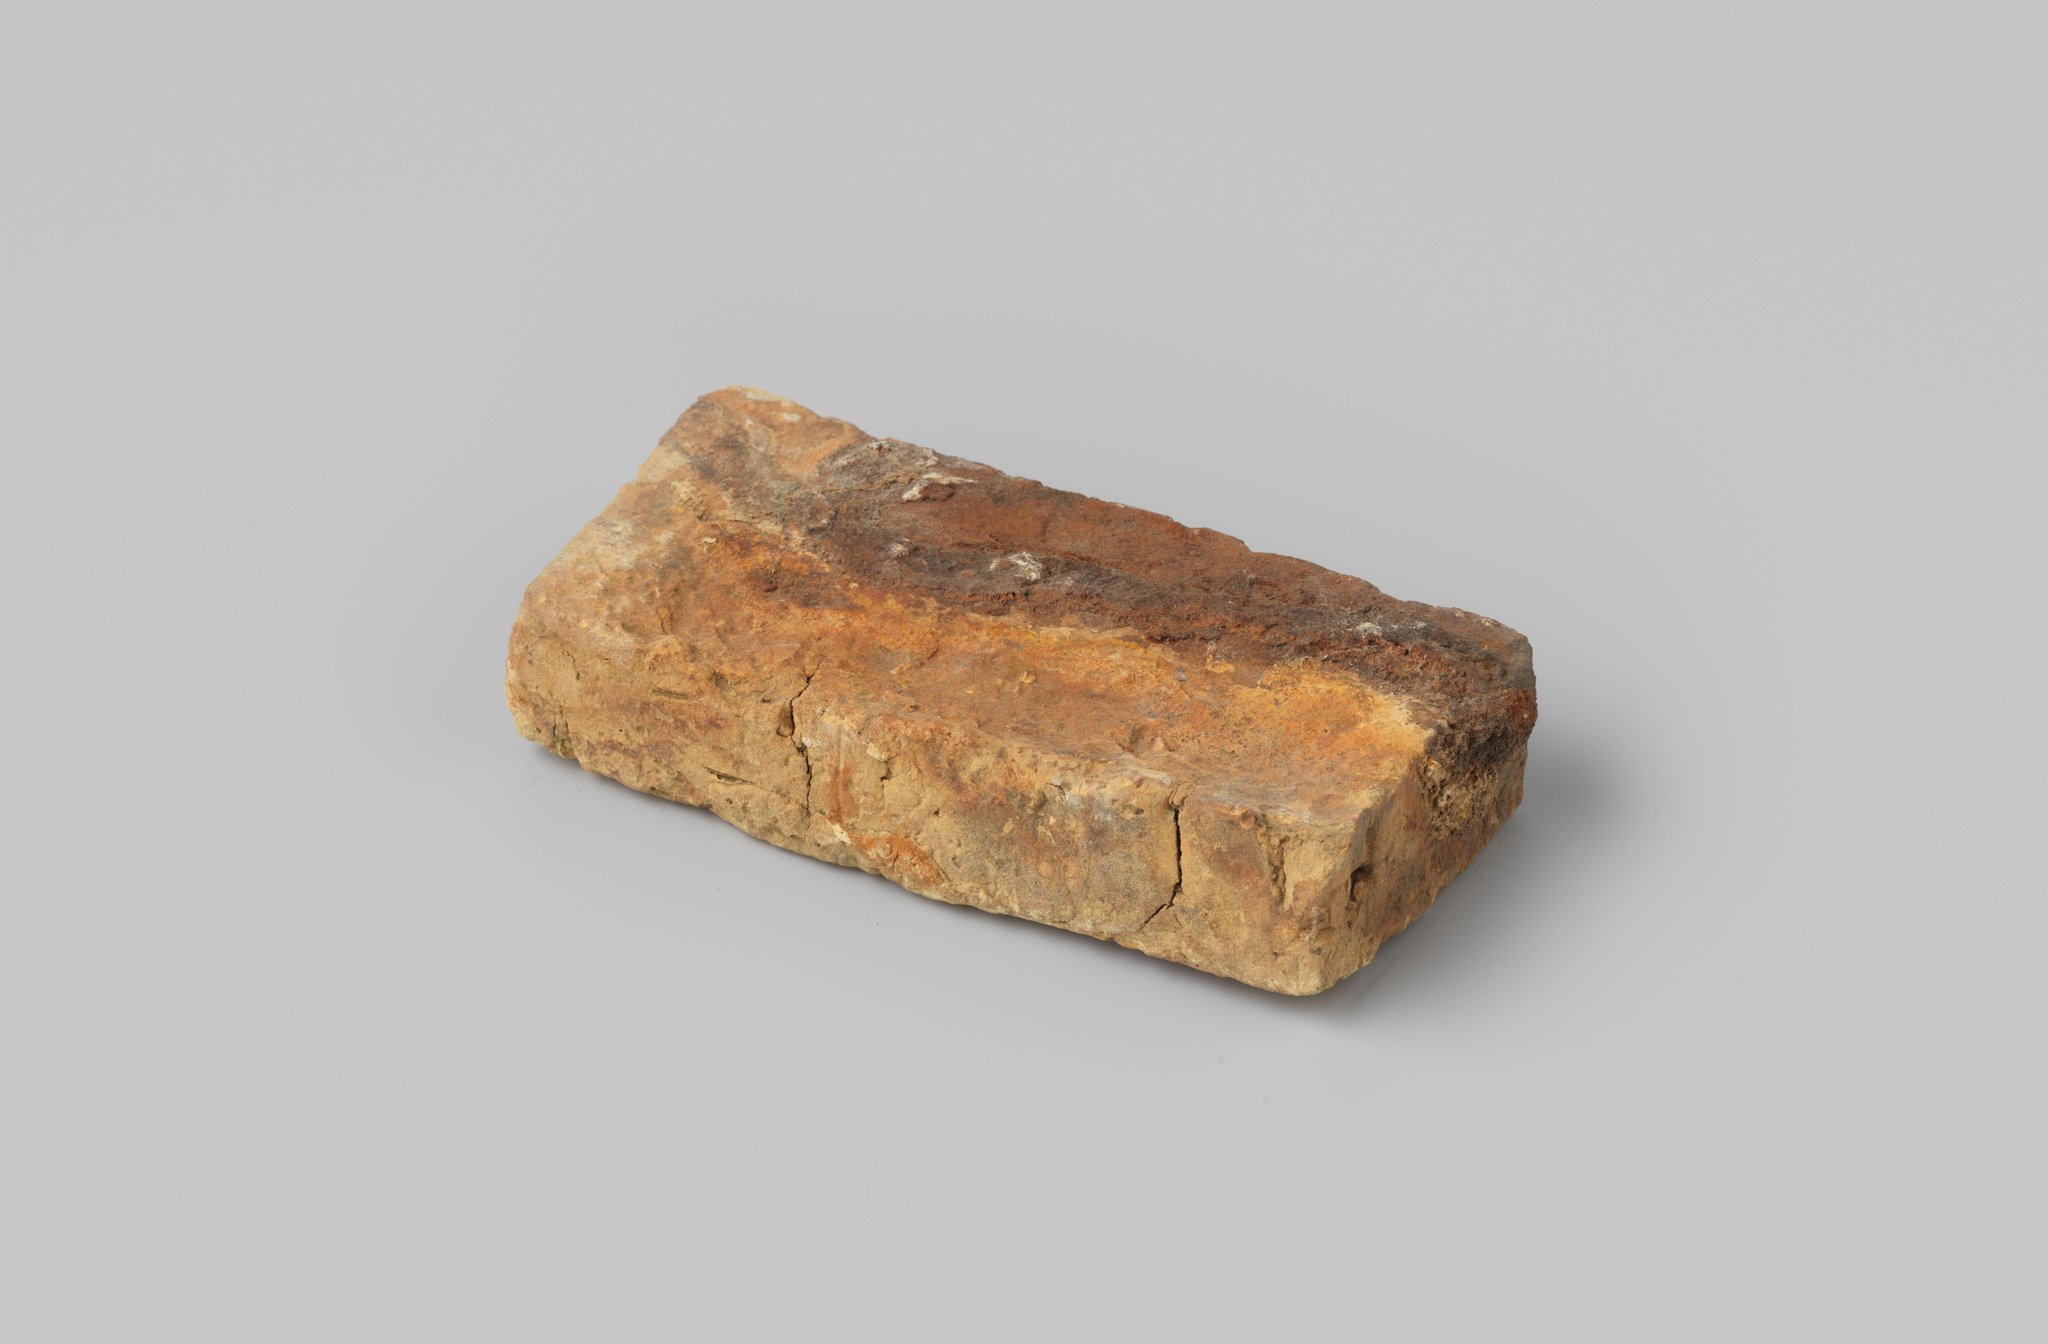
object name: brick clay product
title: Baksteen uit het wrak van de Oost-Indiëvaarder Hollandia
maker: Anonymous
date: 1700-1743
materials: brick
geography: netherlands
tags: verenigde oostindische compagnie, hollandia (schip), annet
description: Constructional elements, brick; sim. 80H2567, sim. 80H1208, sim. 80H1009.